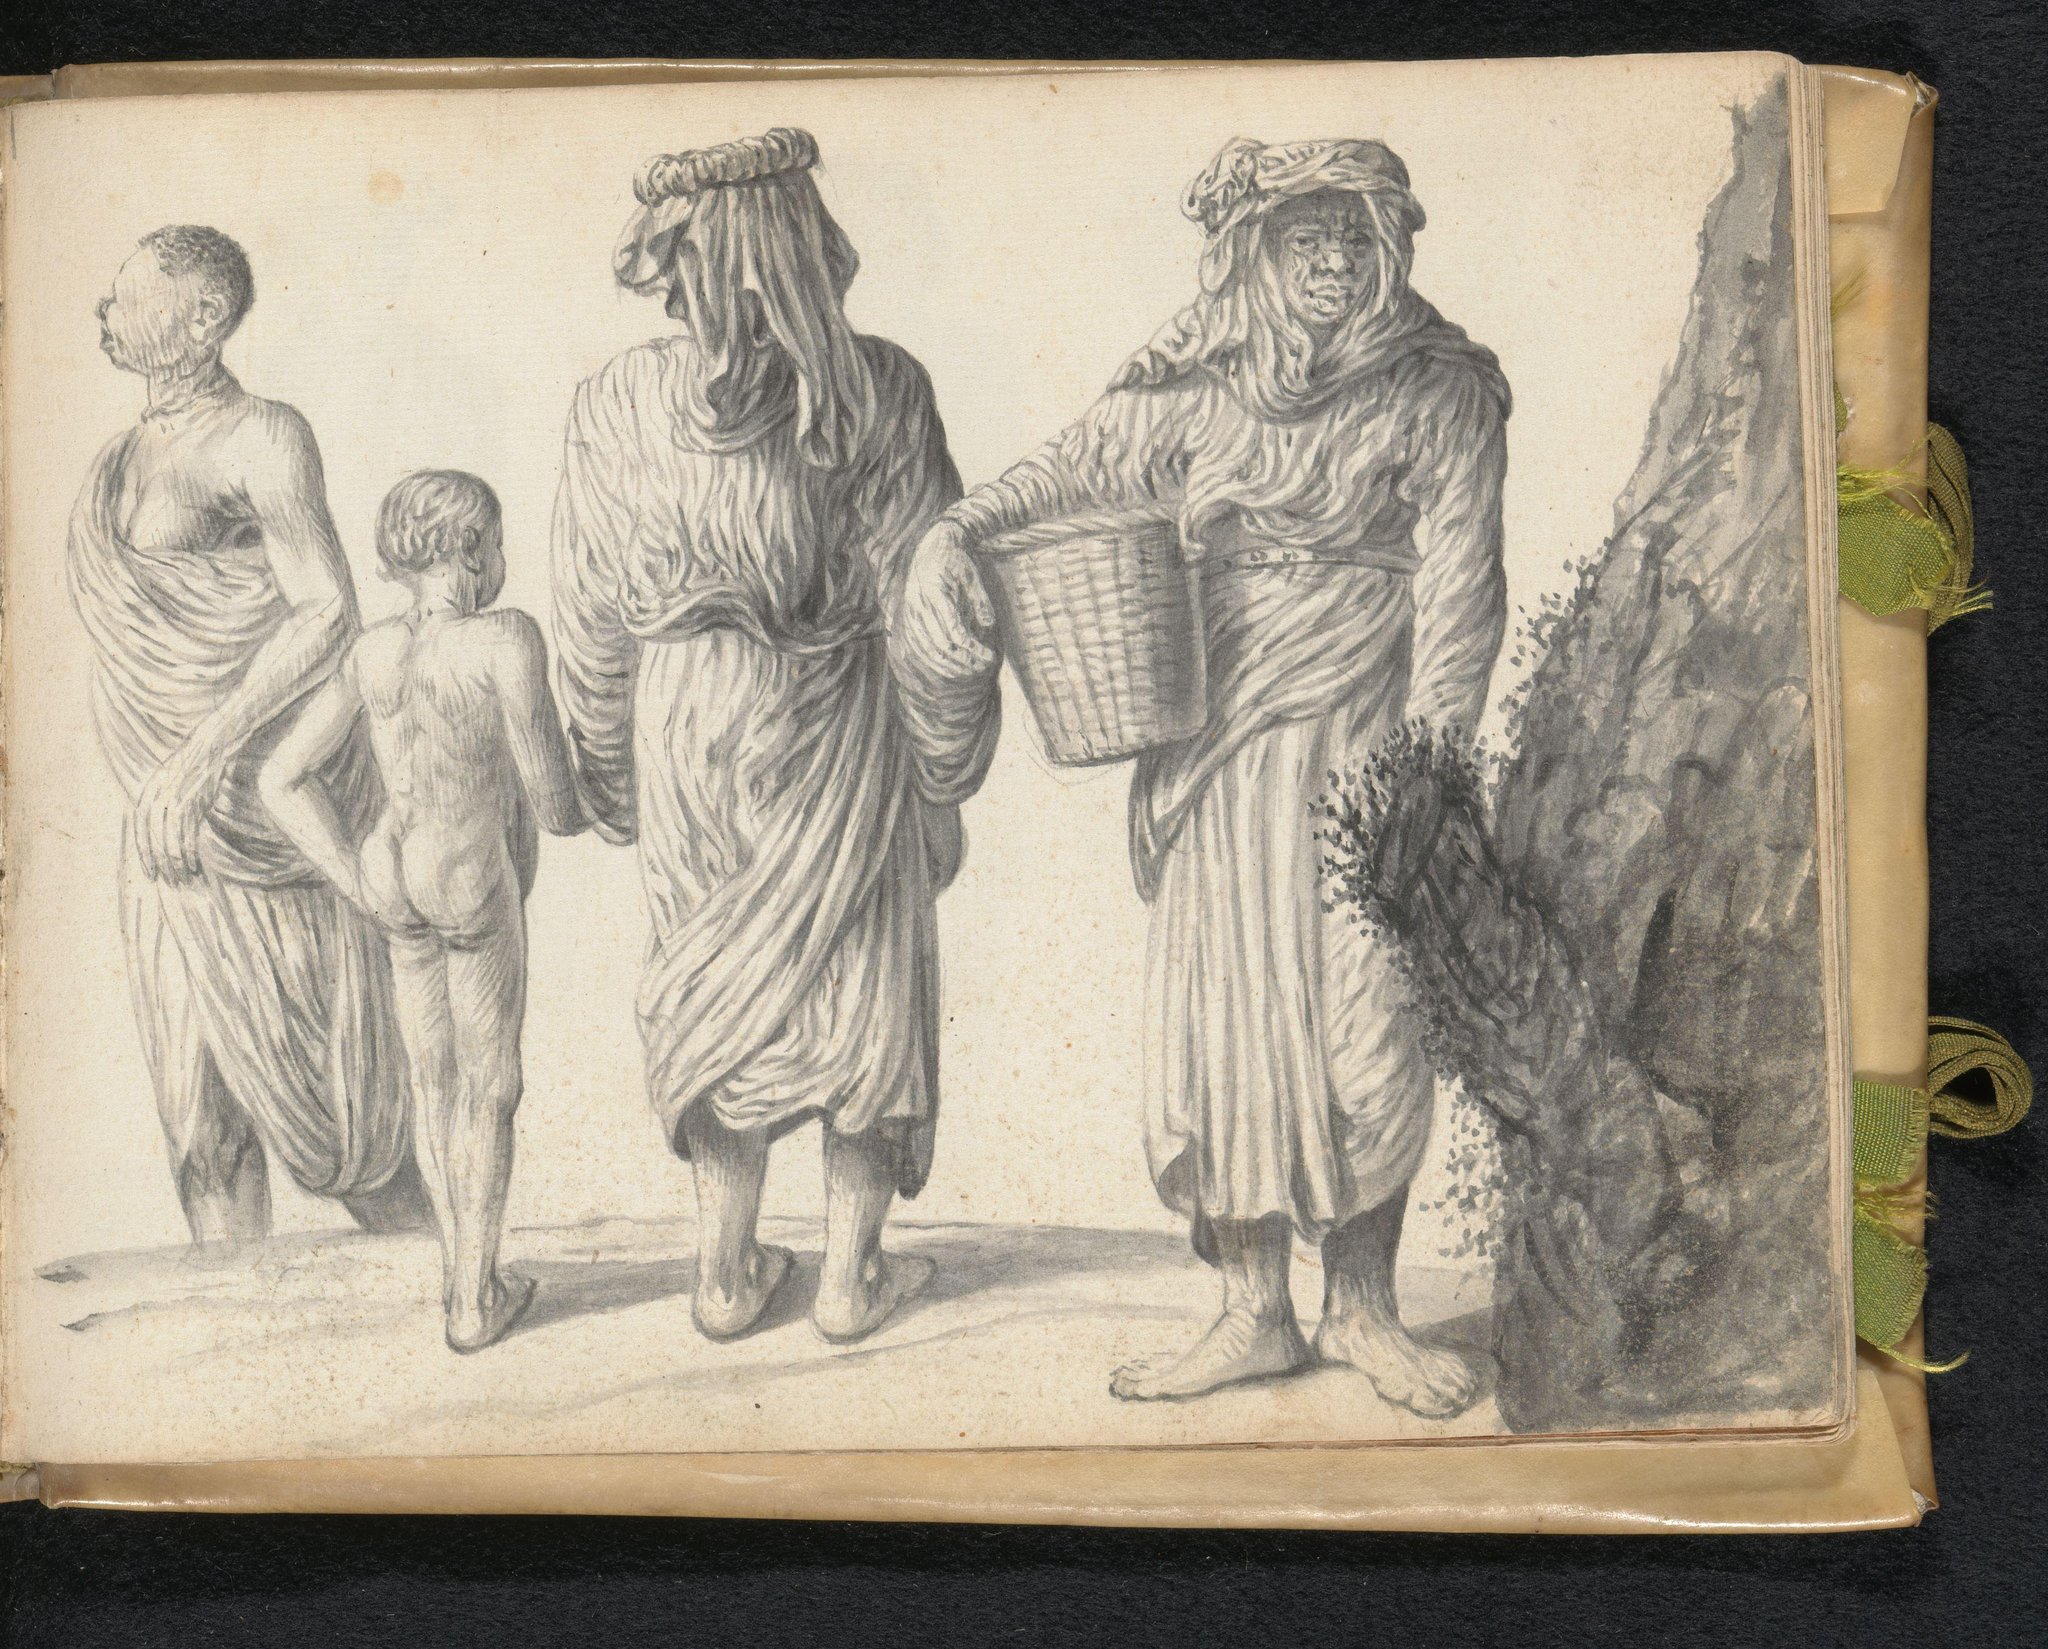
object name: sketchbook leaf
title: Three women and a child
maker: esaias boursse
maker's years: 1631-1672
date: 1662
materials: ink, paper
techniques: brush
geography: sri lanka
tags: eurasion, half-caste, skirt (with name), clothing for the upper part of the body (with name), clothes covering the entire body (with name), asiatic races and peoples: indians, sri lanka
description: Links loopt een vrouw het beeld uit. Ze draagt een Zuid-Indiaas wikkelkleed (selai of sari) waarvan het uiteinde over haar rechterschouder naar voren valt en haar borsten bedekt. Ze heeft kort kroeshaar, mogelijkerwijs een arbeidster uit Zuid-India. Daarnaast staat een ongekleed kind: een jongen of een meisje, waarschijnlijk Euraziatisch. Het kind heeft kort golvend haar naar achter gekamd en houdt met de rechterhand de naast hem staande vrouw vast. Die vrouw draagt een wikkelrok (redda) met daarboven een wijde Portugese bloes met lange mouwen (hatte). Het omgeklapte 'kraagje' van de niet zichtbare V-hals is duidelijk te zien. Ze draagt een hoofddoek met daarop een draagring. De vrouw rechts is gekleed in een lange wikkelrok (redda) en een wijde Portugese bloes met lange mouwen (hatte). Om het hoofd en om de hals is een doek gewikkeld met bovenop een draagring. Met haar rechterarm houdt ze een rieten mand tegen haar heup. Mogelijk heeft ze een draagriem om haar middel. Blad 104 uit een schetsboek met 117 bladen.